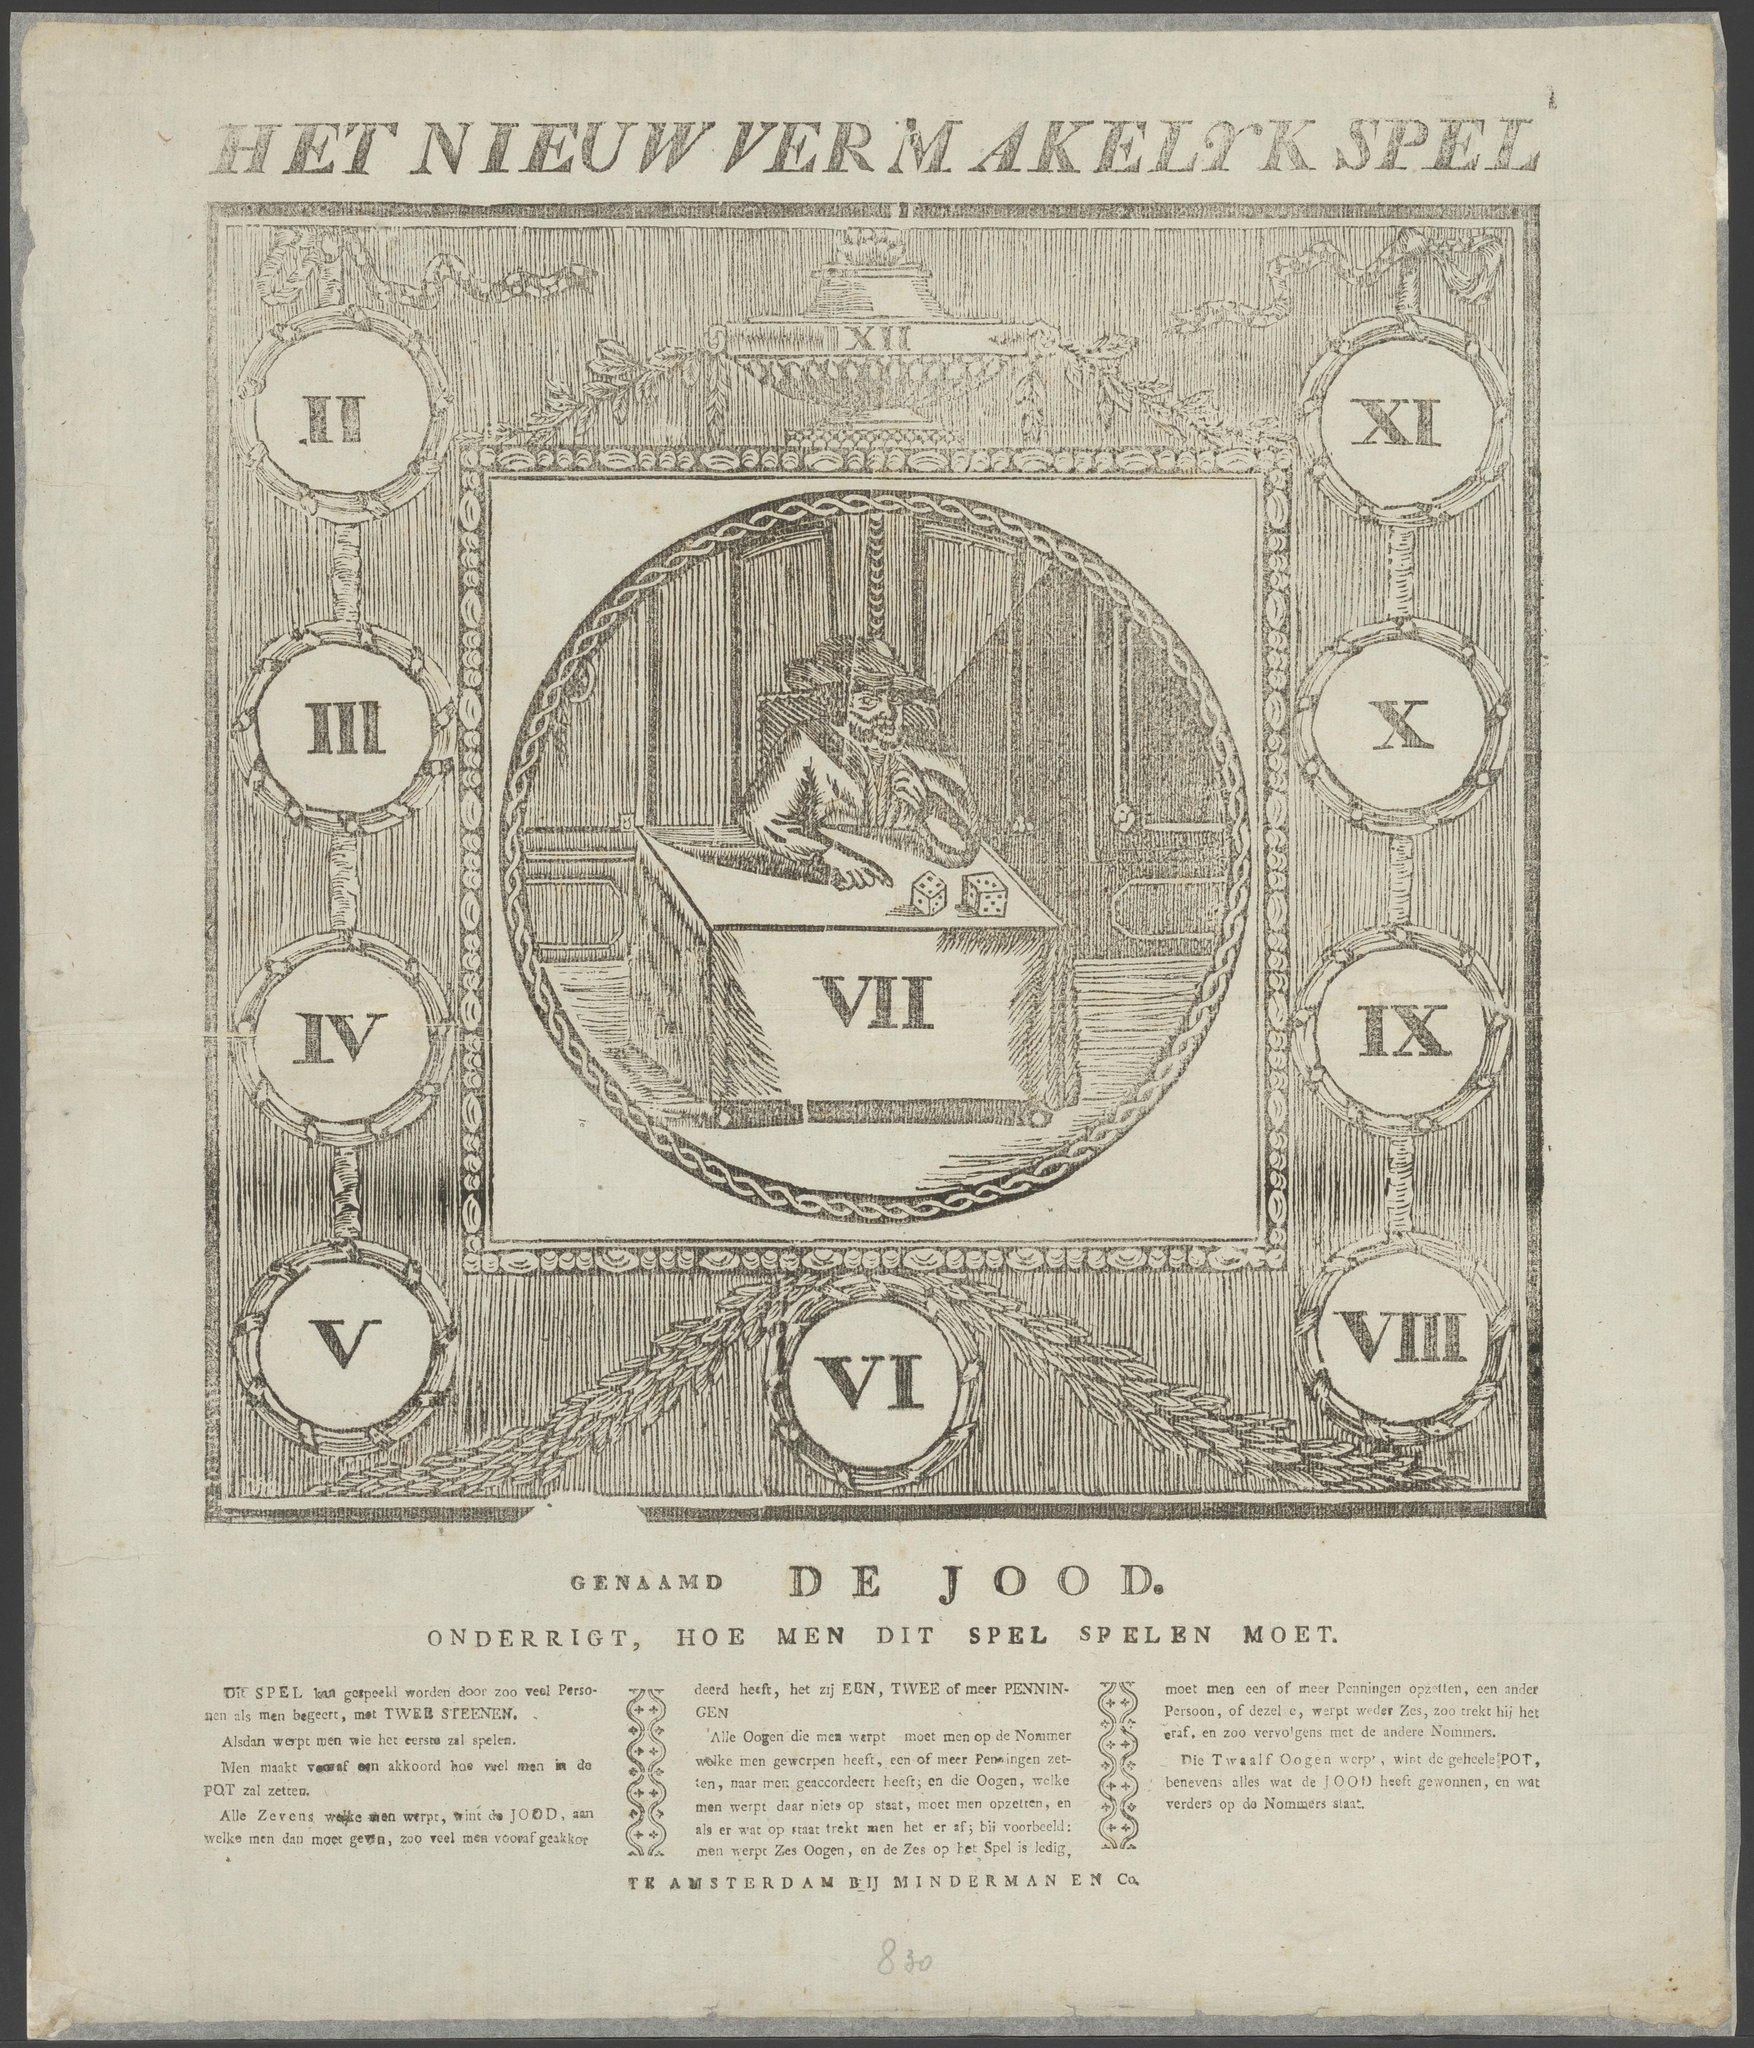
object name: gameboard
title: Bordspel met een Joodse man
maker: jan oortman (sr.)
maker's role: print maker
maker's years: 1753-1823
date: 1814-1848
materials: paper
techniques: letterpress printing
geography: amsterdam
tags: board-games of chance, dice-games, dice, board-games, the jews, jewish life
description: Vierkant bordspel met in het midden een cirkel waarin een Jood met hoed op aan tafel zit. Op tafel liggen twee dobbelstenen. Om de cirkel in kleine cirkels de romeinse cijfers 2 tot en met 12. De Jood is nummer 7. Onder de voorstelling de spelregels in drie kolommen. Onderwerpsrubrieken binnen de Atlas Zeden en Gewoonten: Zeden en gewoonten in engeren zin, Spel en vermaak, Gezelschapsspel II, Ganzenbord en dergelijke.